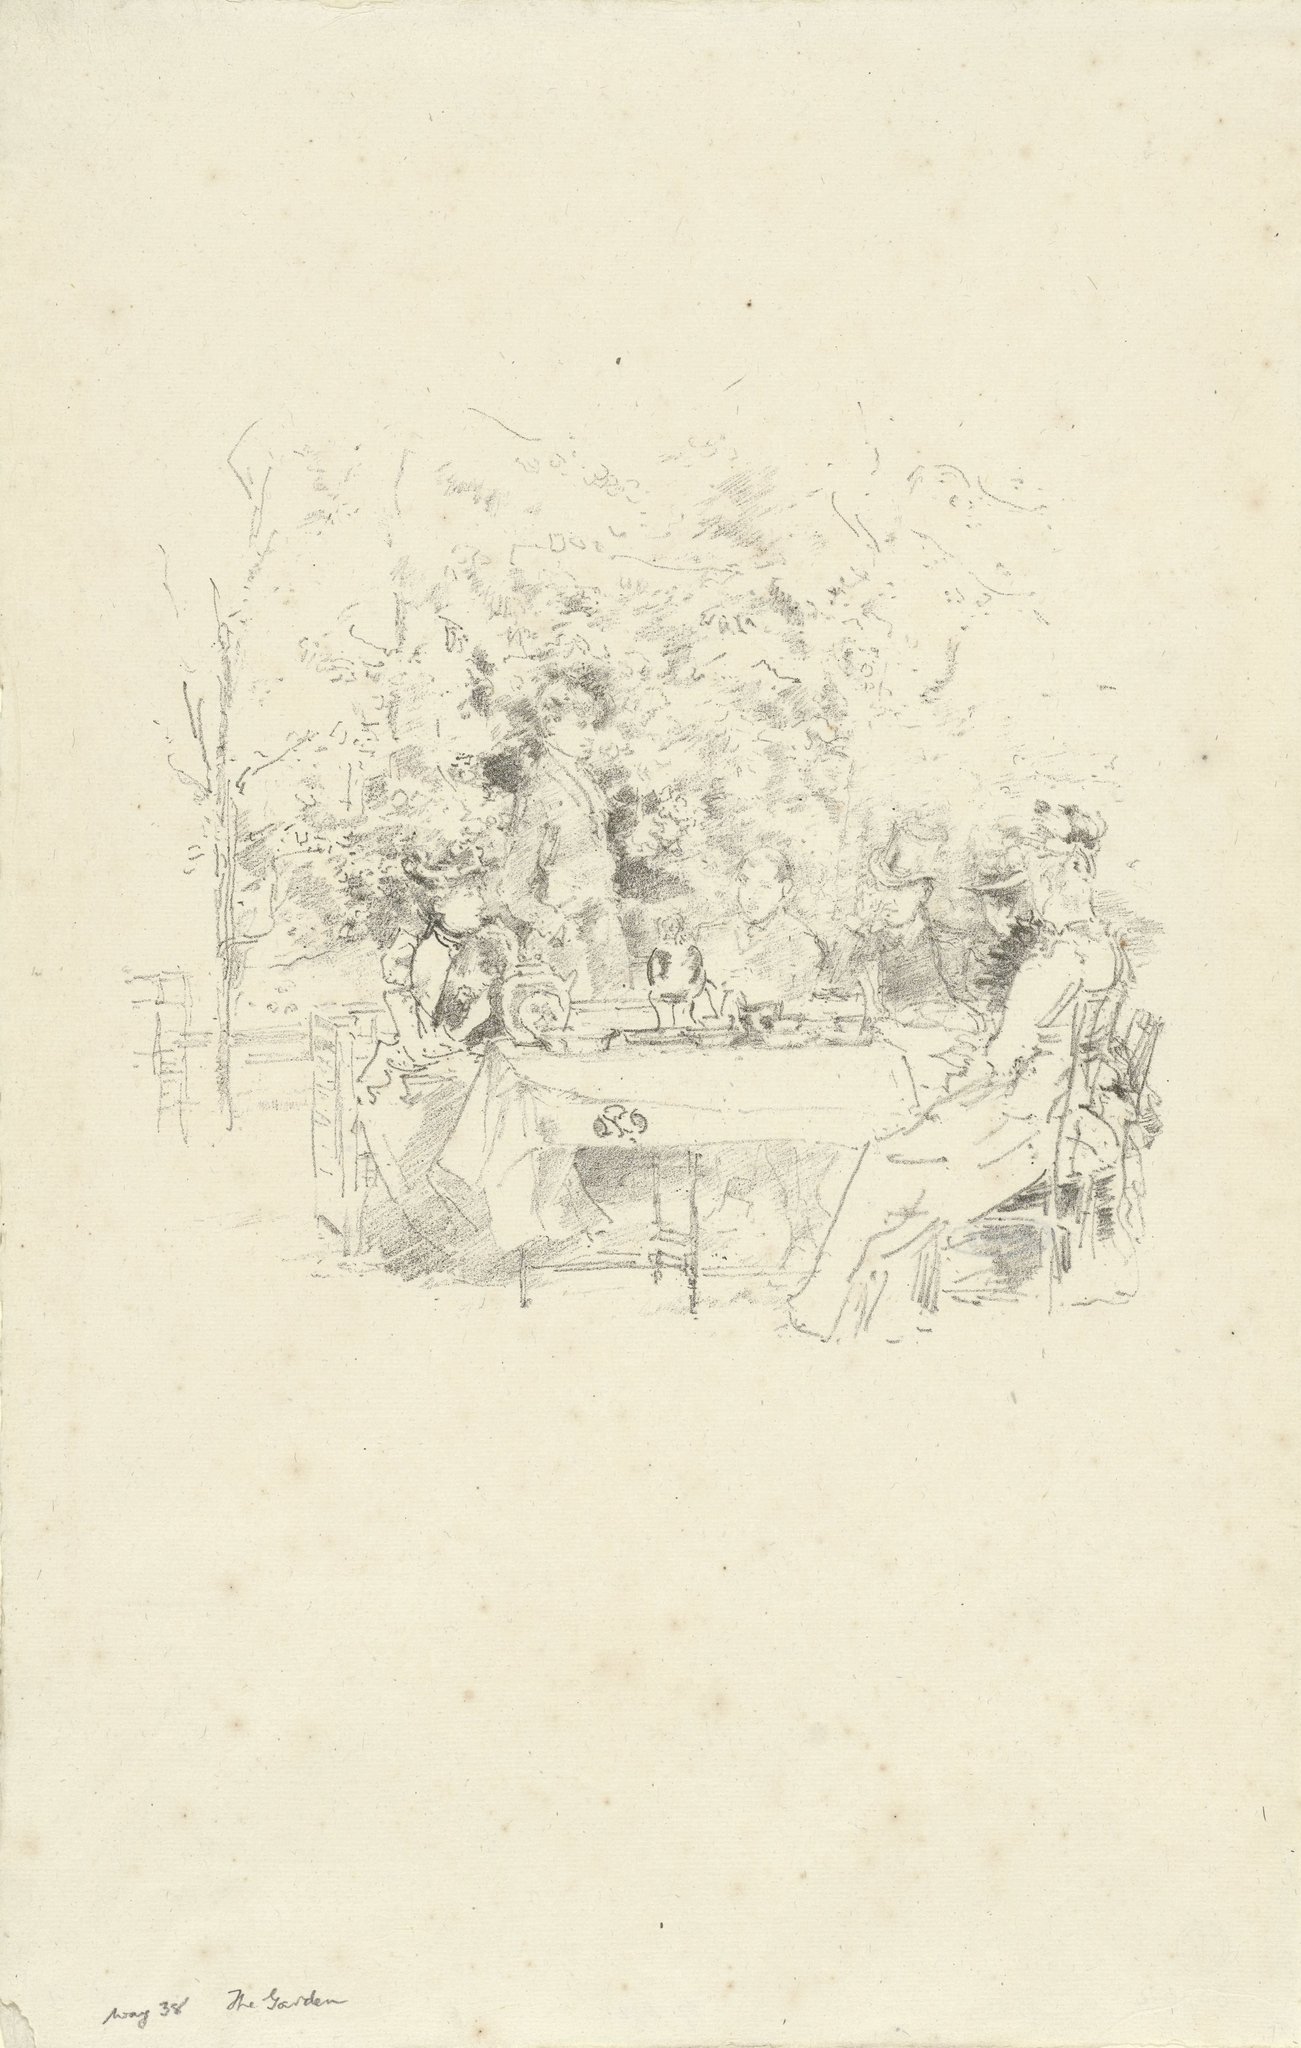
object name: print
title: The Garden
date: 1806-1891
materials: paper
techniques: lithograph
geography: london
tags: print maker, walter richard sickert, liverpool, high tea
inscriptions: collector's mark: Lugt 2228, collector's mark: Lugt 405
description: Gezelschap tijdens de thee in de tuin van de kunstenaars. Rond de tafel van links naar rechts: de vrouw van Brandon Thomas, Walter Sickert, Sidney Starr, Brandon Thomas, Beatrix Whistler and Ethel Birnie Philip.